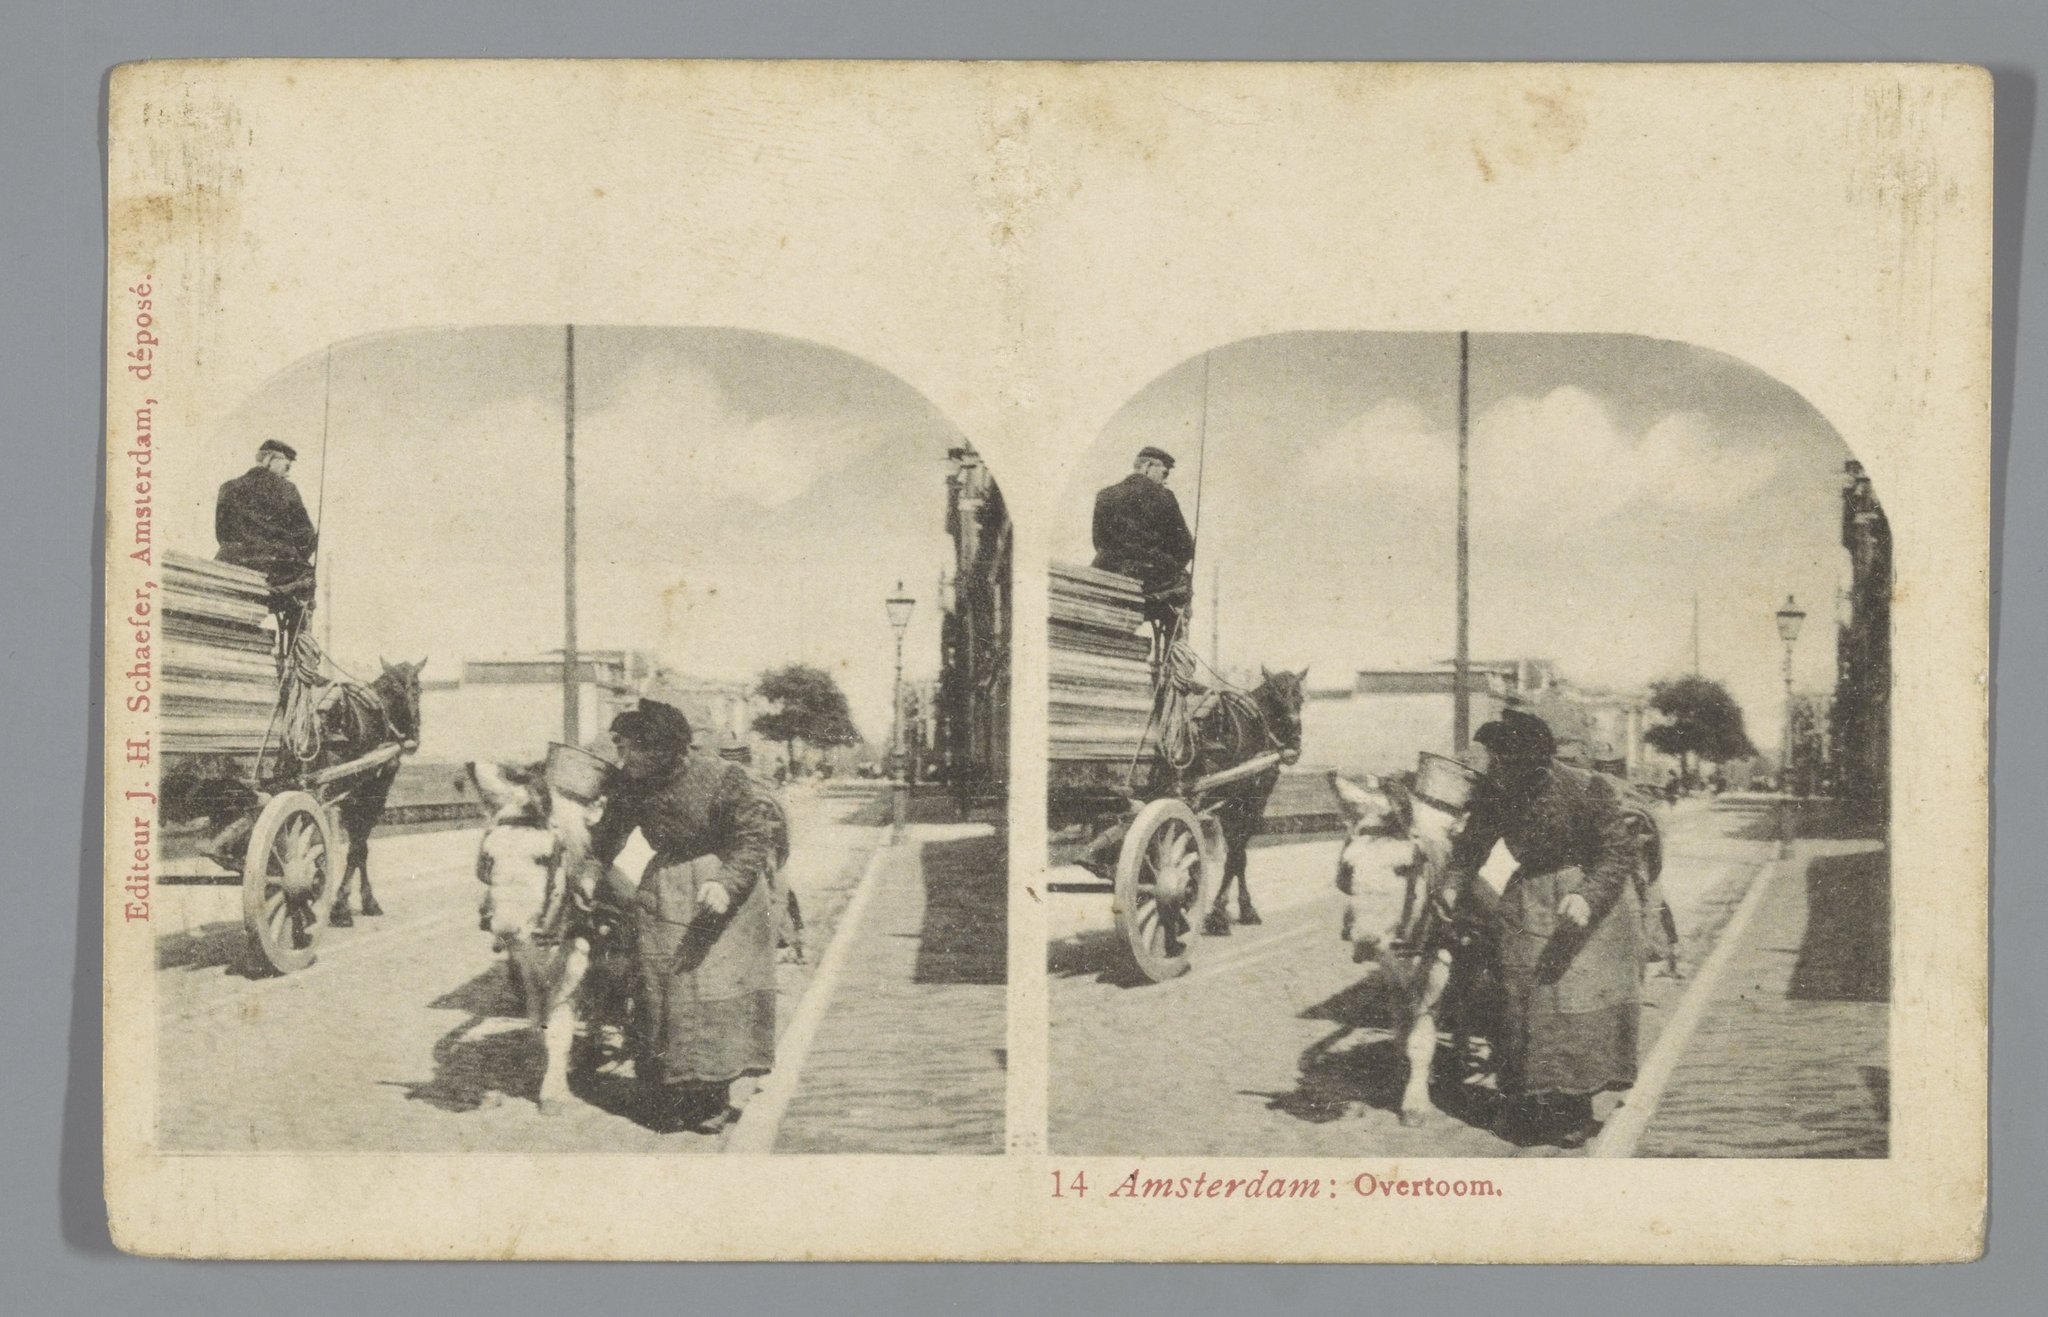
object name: ansichtkaart, prentbriefkaart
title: Amsterdam: Overtoom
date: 1896-1905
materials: cardboard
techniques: photograph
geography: amsterdam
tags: four-wheeled vehicle drawn by one animal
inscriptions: number: ‘14’, inscription: ‘Briefkaart/ Aan...’